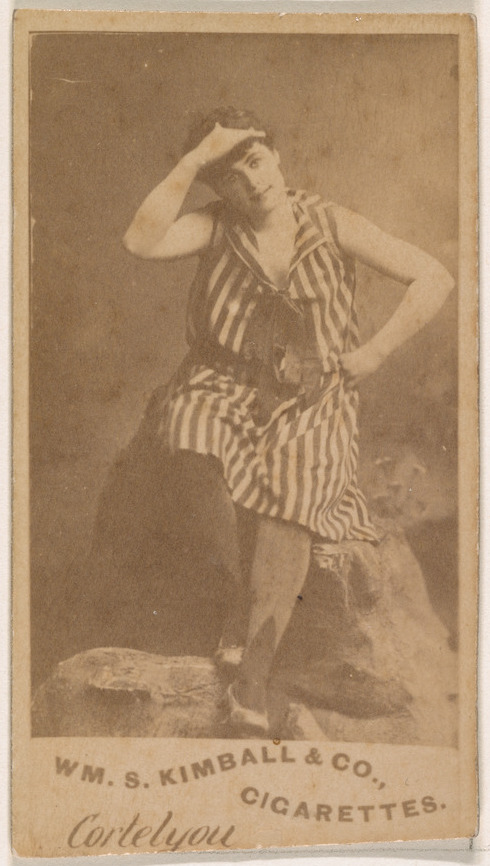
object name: photograph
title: Miss Cortelyou, from the Actresses series (N203) issued by Wm. S. Kimball & Co.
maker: william s. kimball & company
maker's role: publisher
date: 1889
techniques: color lithograph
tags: portraits,women,actresses